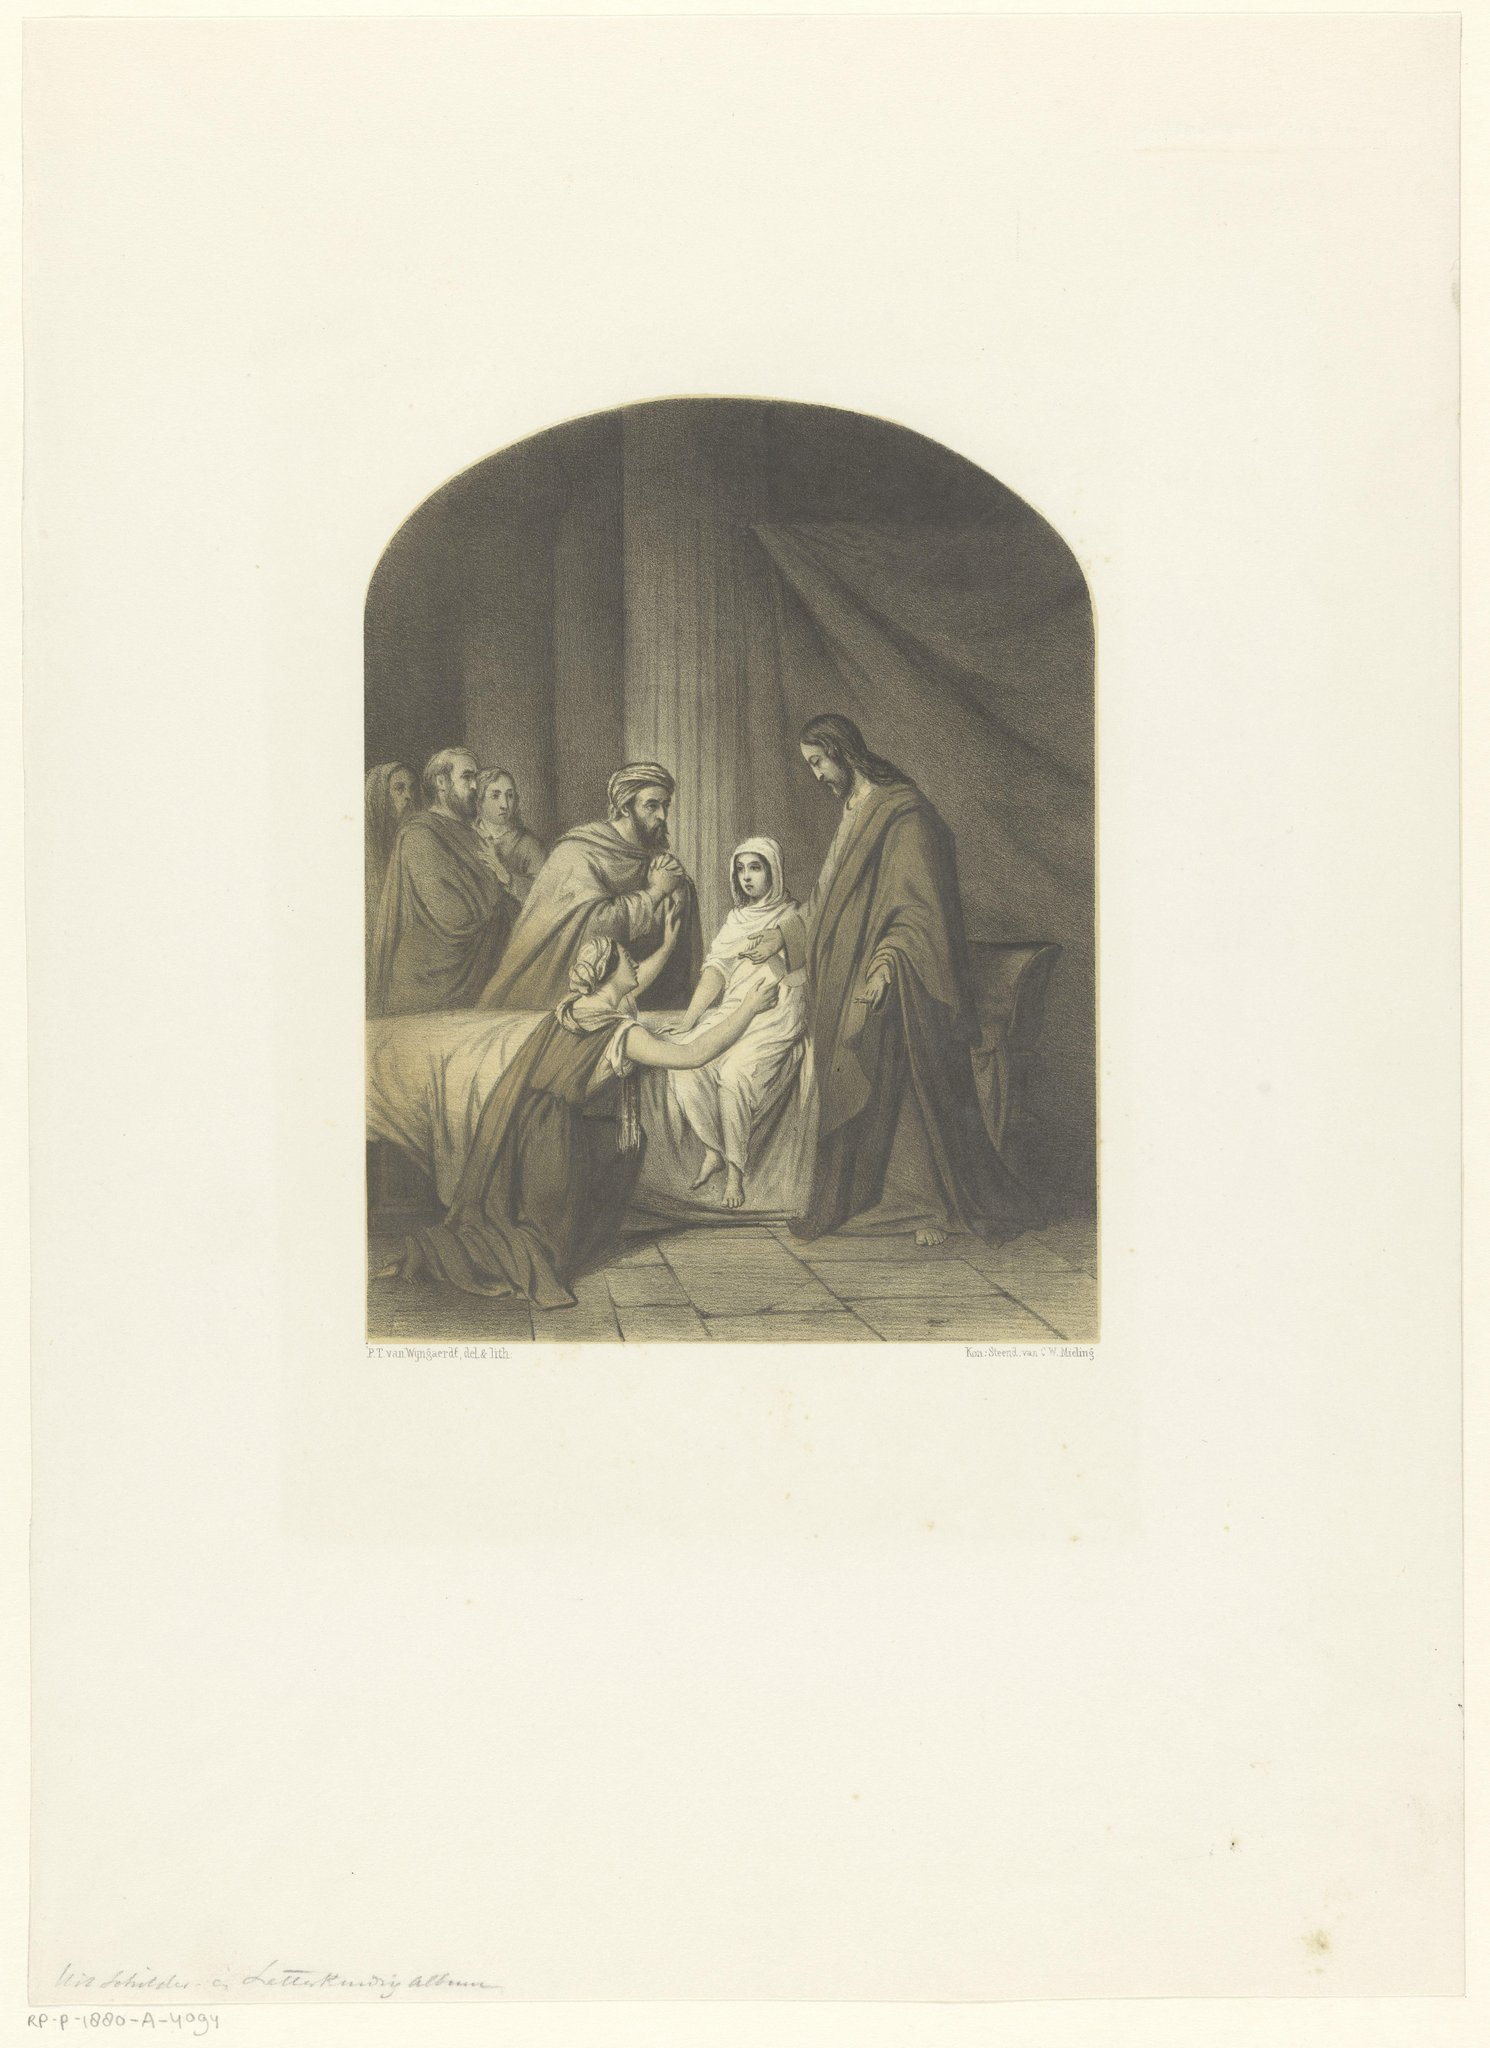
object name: print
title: Opwekking van de dochter van Jaïrus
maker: petrus theodorus van wijngaerdt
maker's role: draughtsman, print maker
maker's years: 1816-1893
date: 1847-1849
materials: paper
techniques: tone lithography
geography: the hague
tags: raising of the daughter of jairus, who is lying in bed (matthew 9:18-19, 9:23-26; mark 5:21-24, 5:35-43; luke 8:40-42, 8:49-56)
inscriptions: collector's mark: Lugt 2228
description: Het meisje zit rechtop in bed, rechts van haar staat Jezus. Jarïus en zijn vrouw zijn in extase. Links drie apostelen.